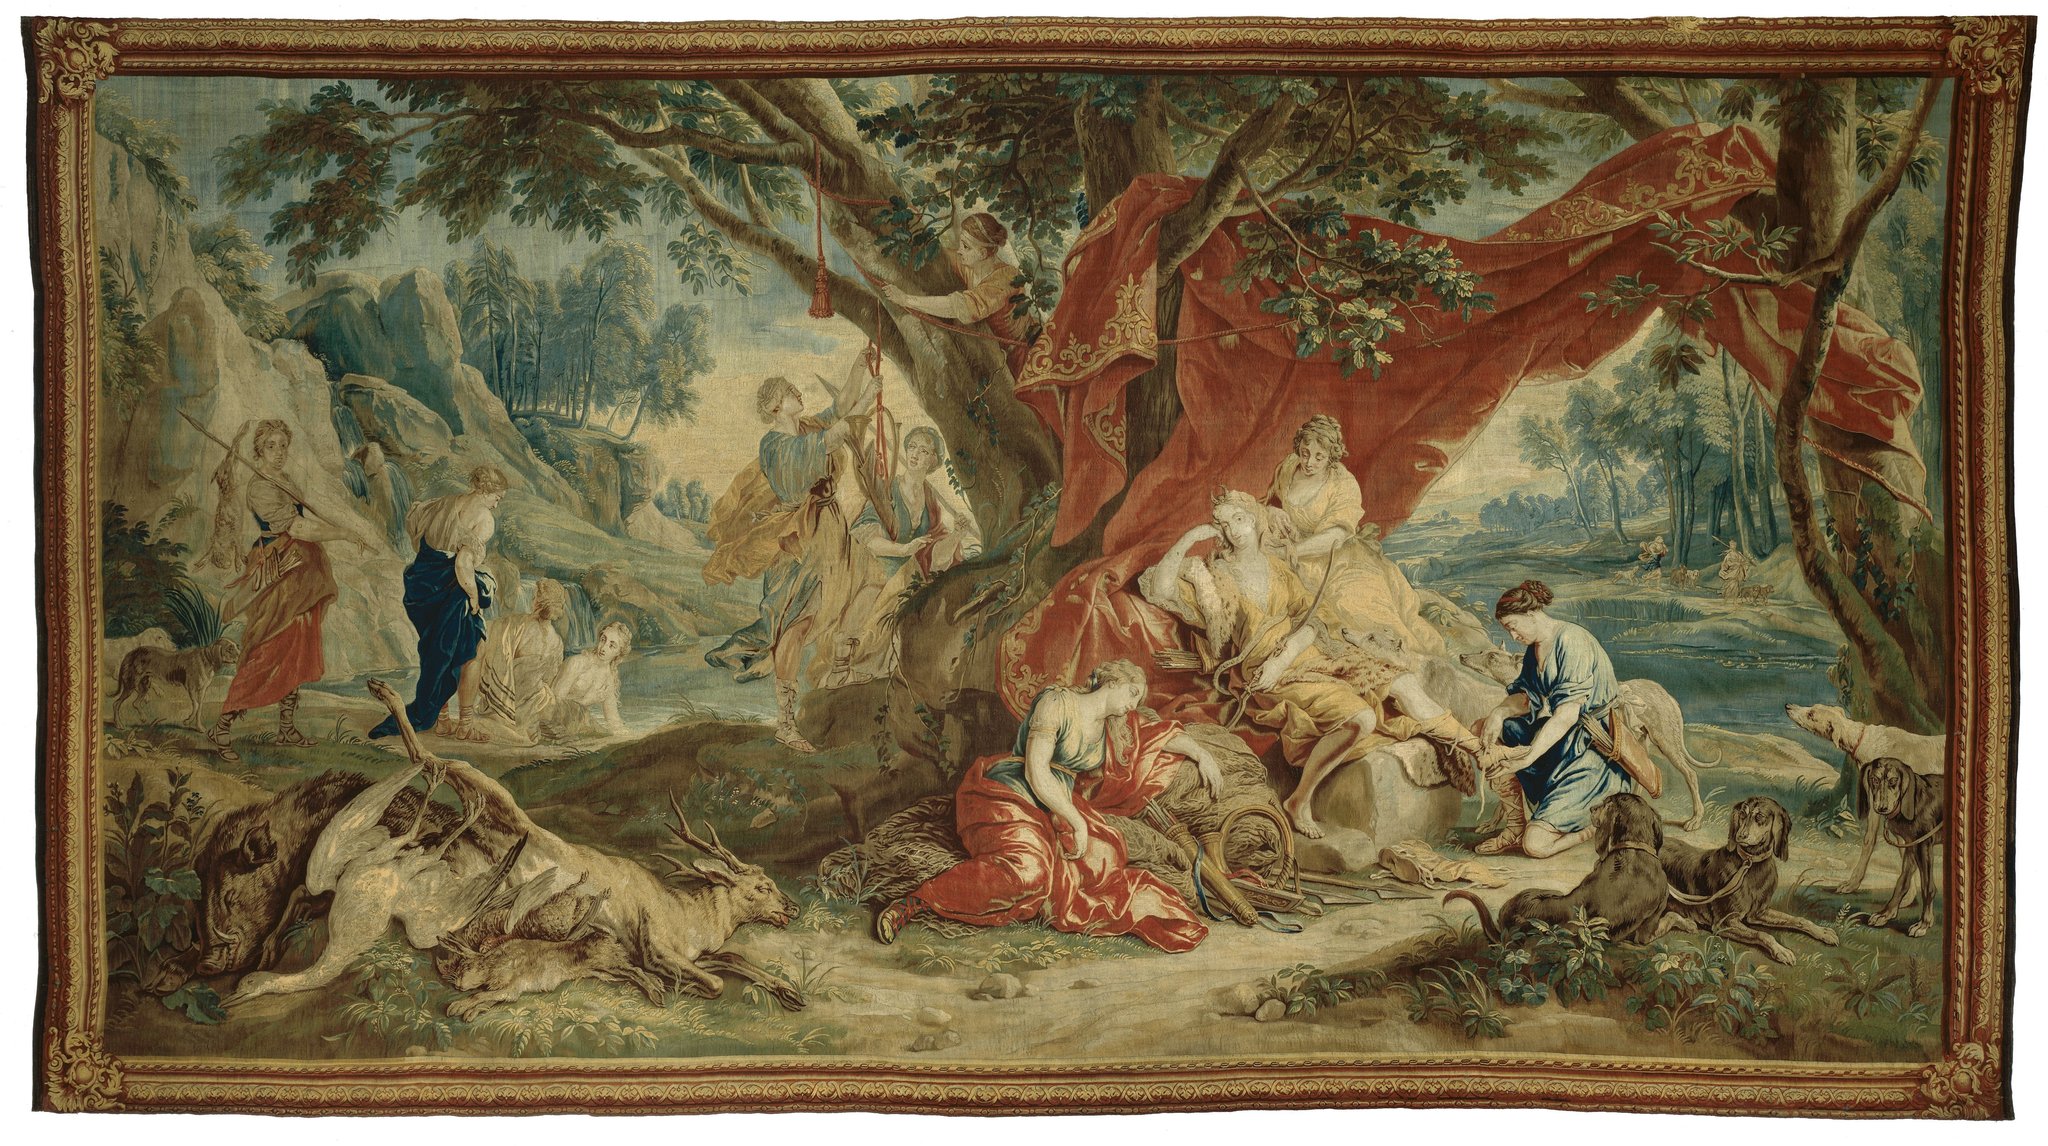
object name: tapestry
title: Rustende Diana, uit de triomfen van de goden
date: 1729-1745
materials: silk, wool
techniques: tapestry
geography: brussels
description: Side-table. Beech, gilded. Munich, c. 1730, possibly designed by Joseph Effner. Attributed to Jean-Louis Lemoyne(1665 - 1755). Elizabeth-Marie-Suzanne Le Detz. Terracotta, marble base. Paris, c. 1720. Two armchairs. Walnut, upholstered with wool and silk embroidery. Netherlands, c. 1715 - 1730. Originally from Kasteel Eerde near Ommen in the province of Overijssel. Tapestry with Diana resting from the hunt, from a set of classical gods. Wool and silk. Brussels, c. 1700 - 1750, probably designed and woven by a member of the Van der Borght family. Given by the Bank voor Handel en Scheepvaart, Rotterdam, 1955.